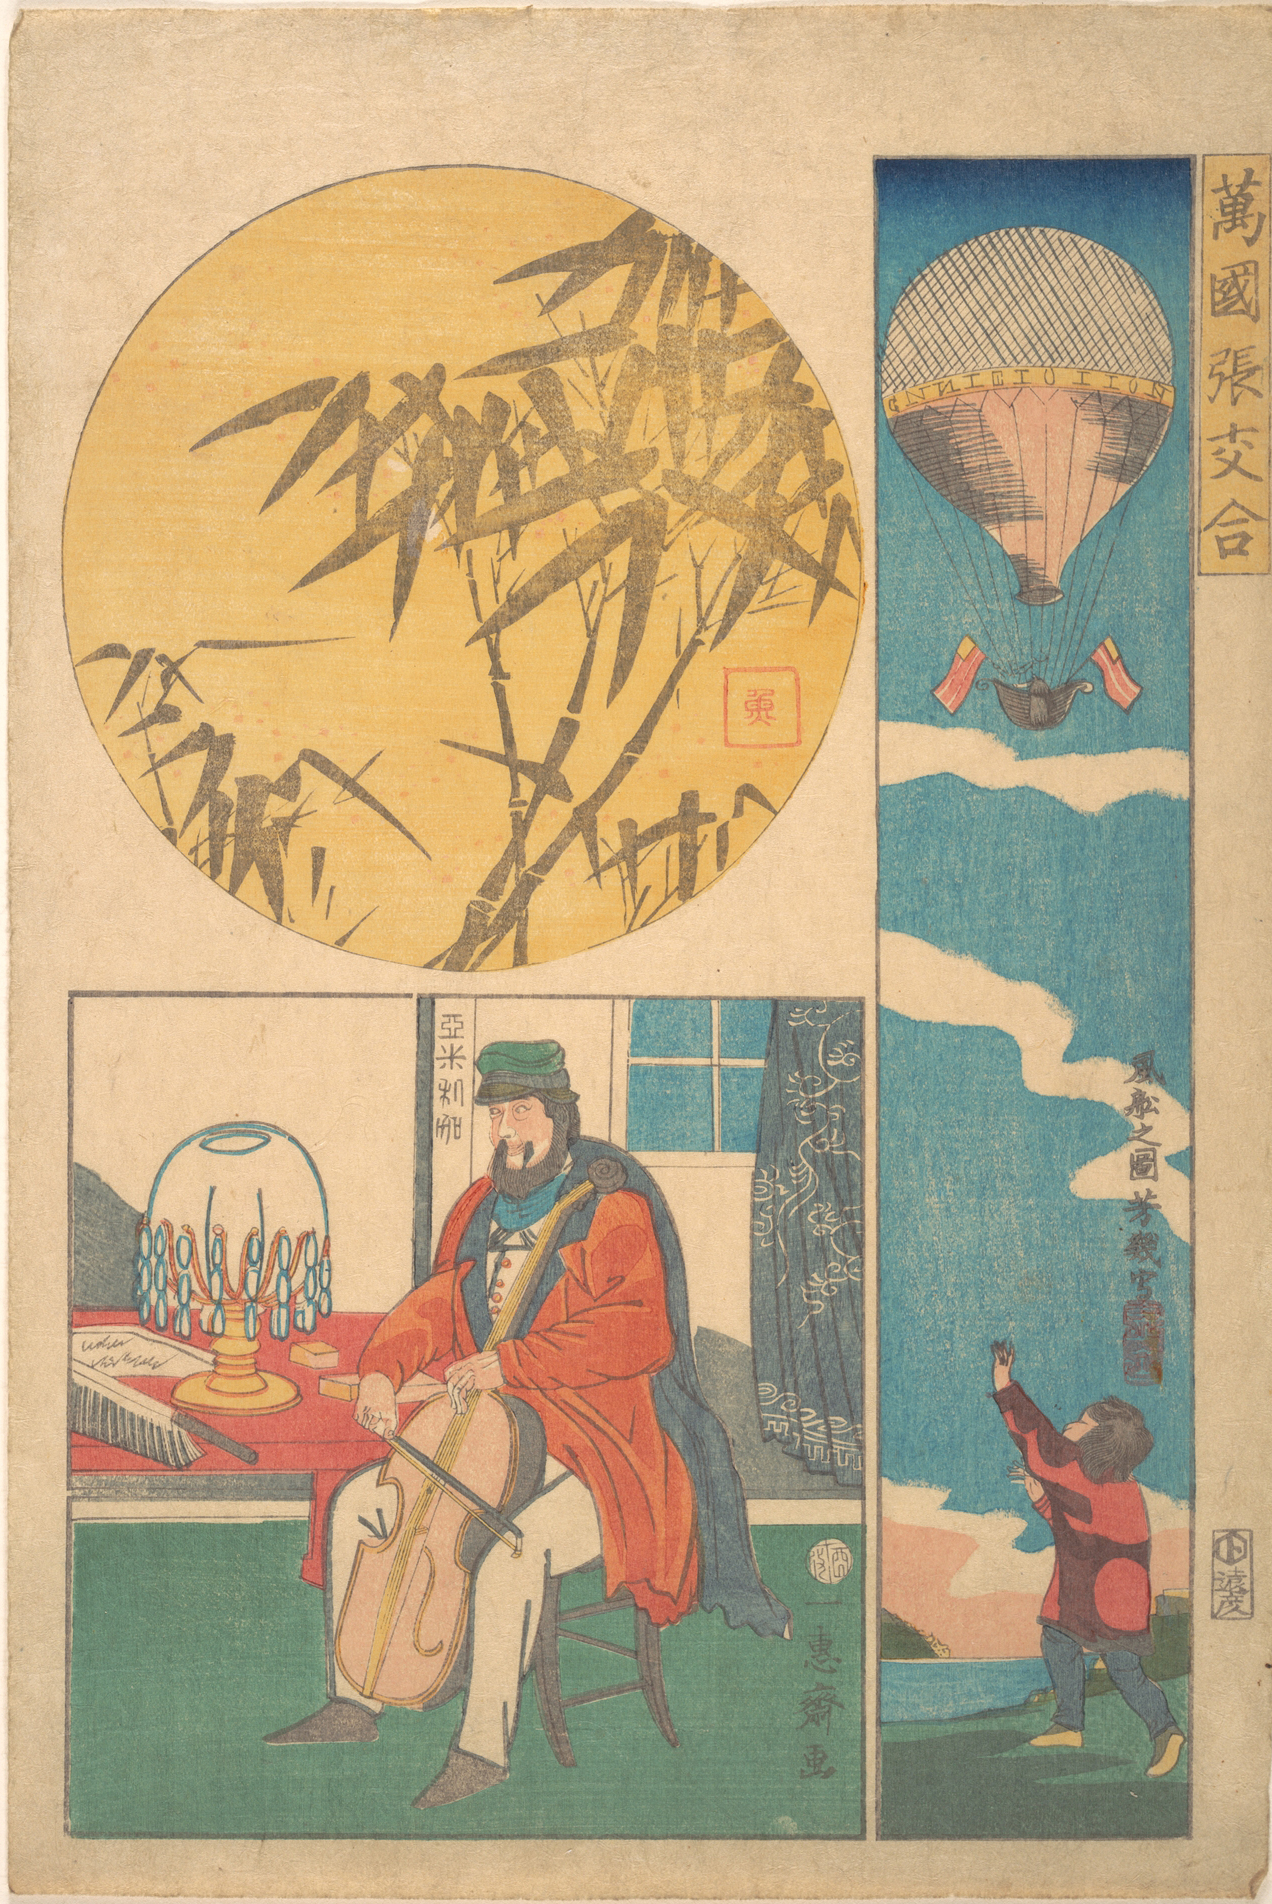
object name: print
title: American Balloon; American Playing Cello; Bamboo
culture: japanese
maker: utagawa yoshiiku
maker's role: artist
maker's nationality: japanese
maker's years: 1833-1904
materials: ink, paper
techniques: woodblock print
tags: men,cellos,bamboo,hot air balloons